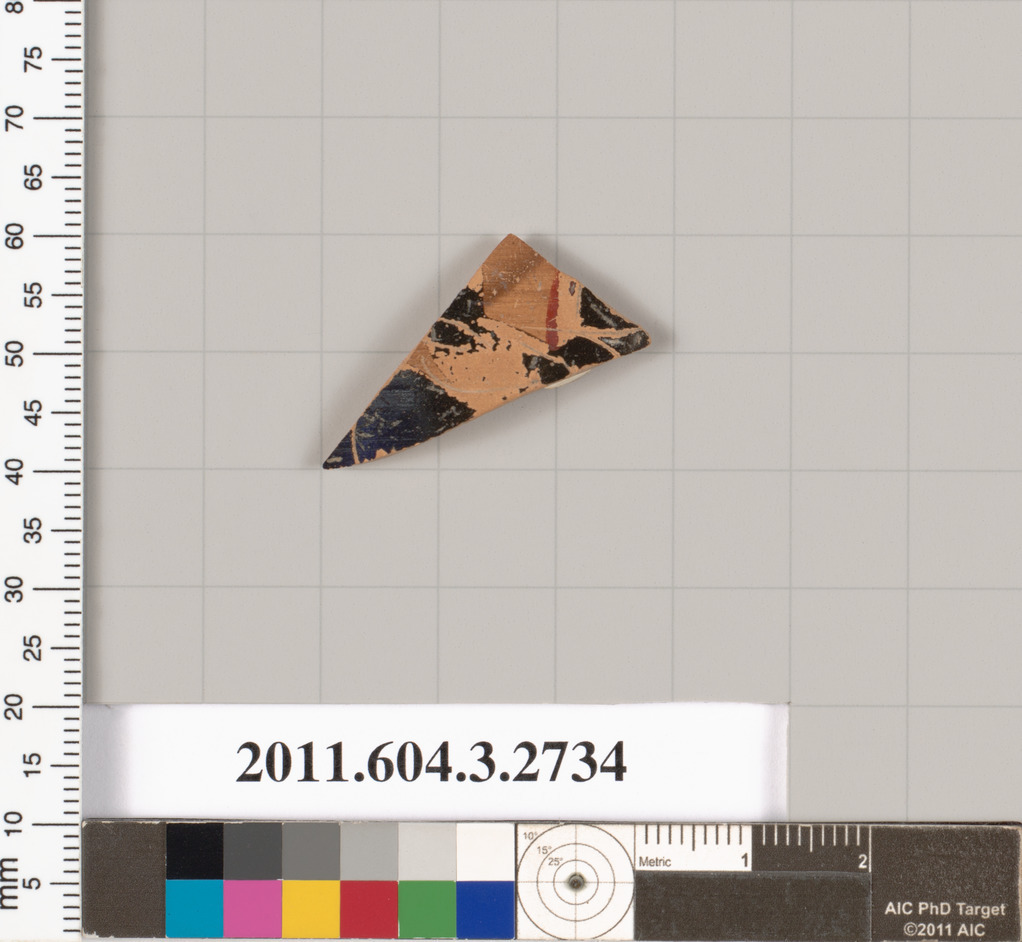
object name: oinochoe fragment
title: Terracotta fragment of an oinochoe (jug)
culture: greek, attic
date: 534-468 BCE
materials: terracotta